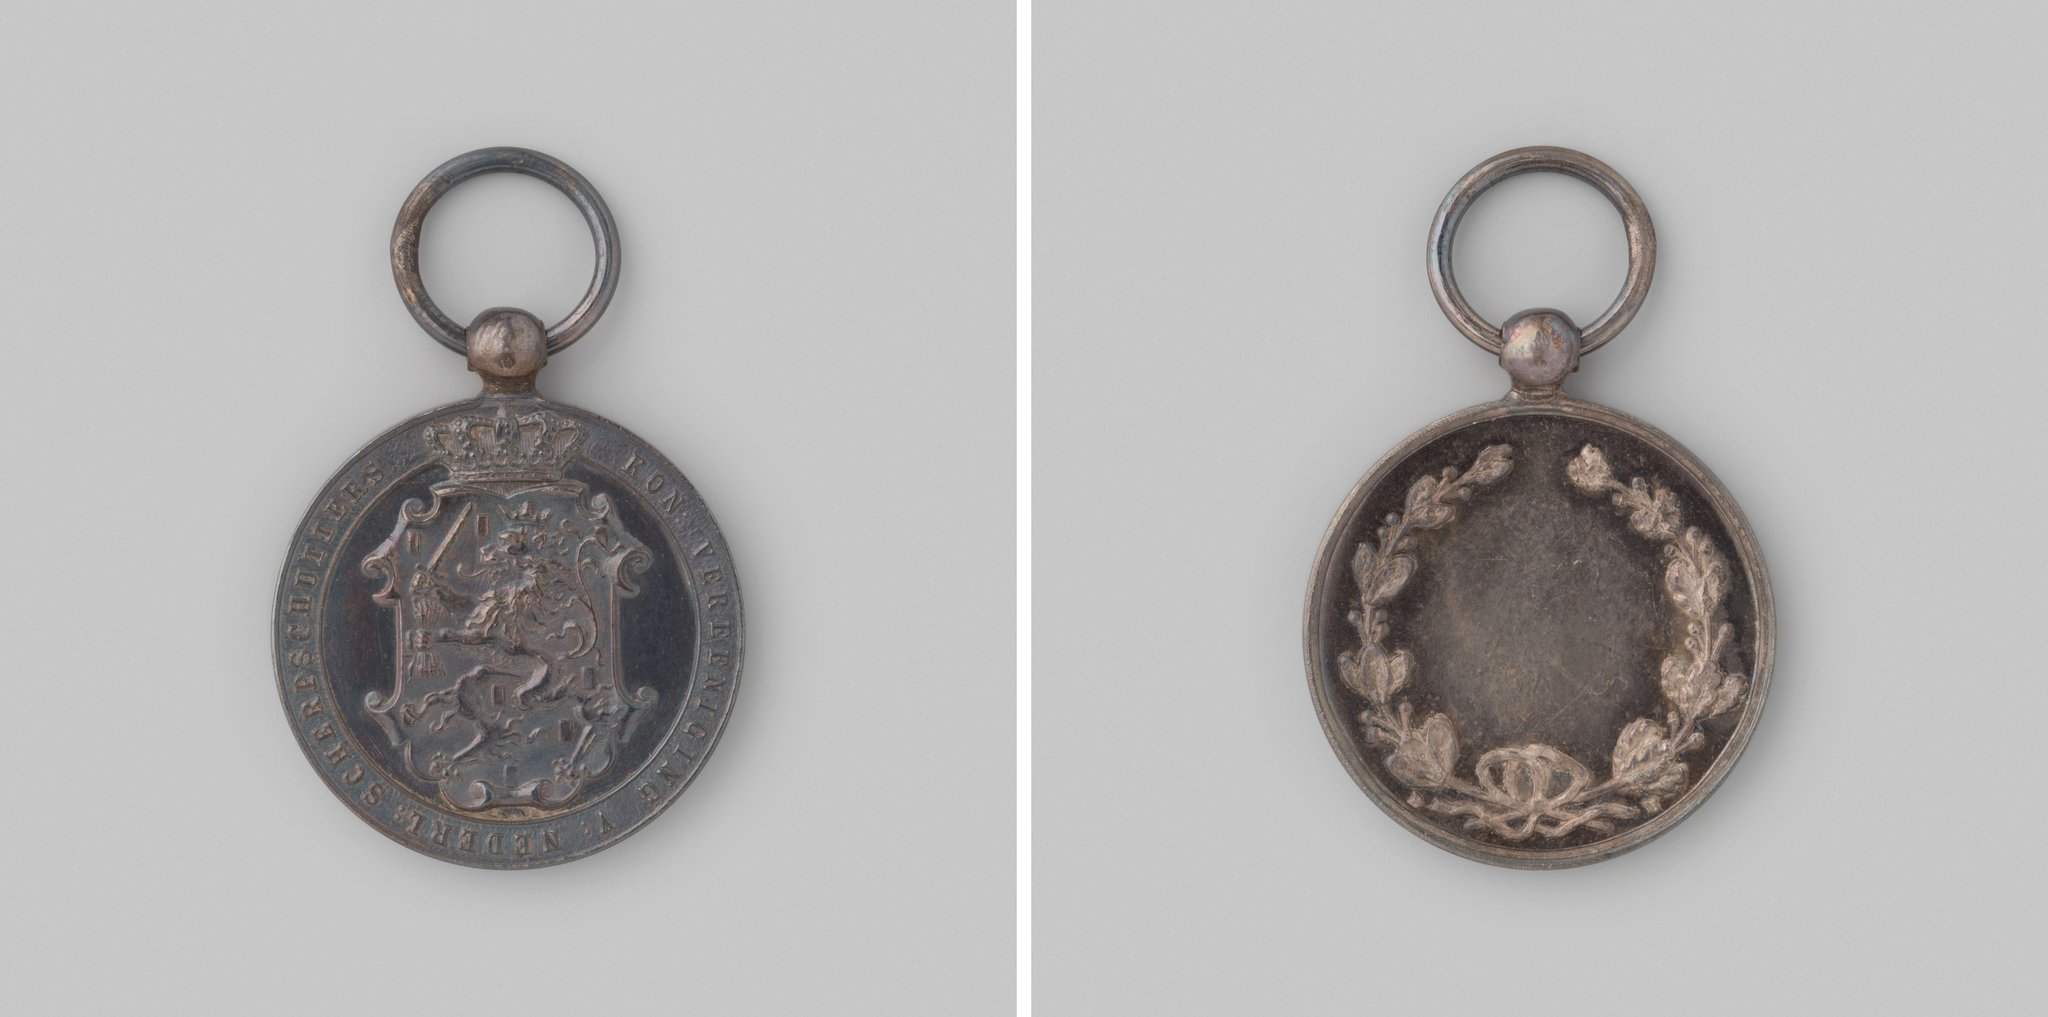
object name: medal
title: Prijspenning van de Vereeniging van Nederlandsche Scherpschutters, 1899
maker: Anonymous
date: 1899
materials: silver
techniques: gilding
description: Verguld zilveren penning met oog en ring van de Vereeniging van Nederlandsche Scherpschutters, behaald door het regiment Schutterij te Amsterdam, 1899. Klein formaat. Voorzijde onbekend. Keerzijde: lauwerkrans.